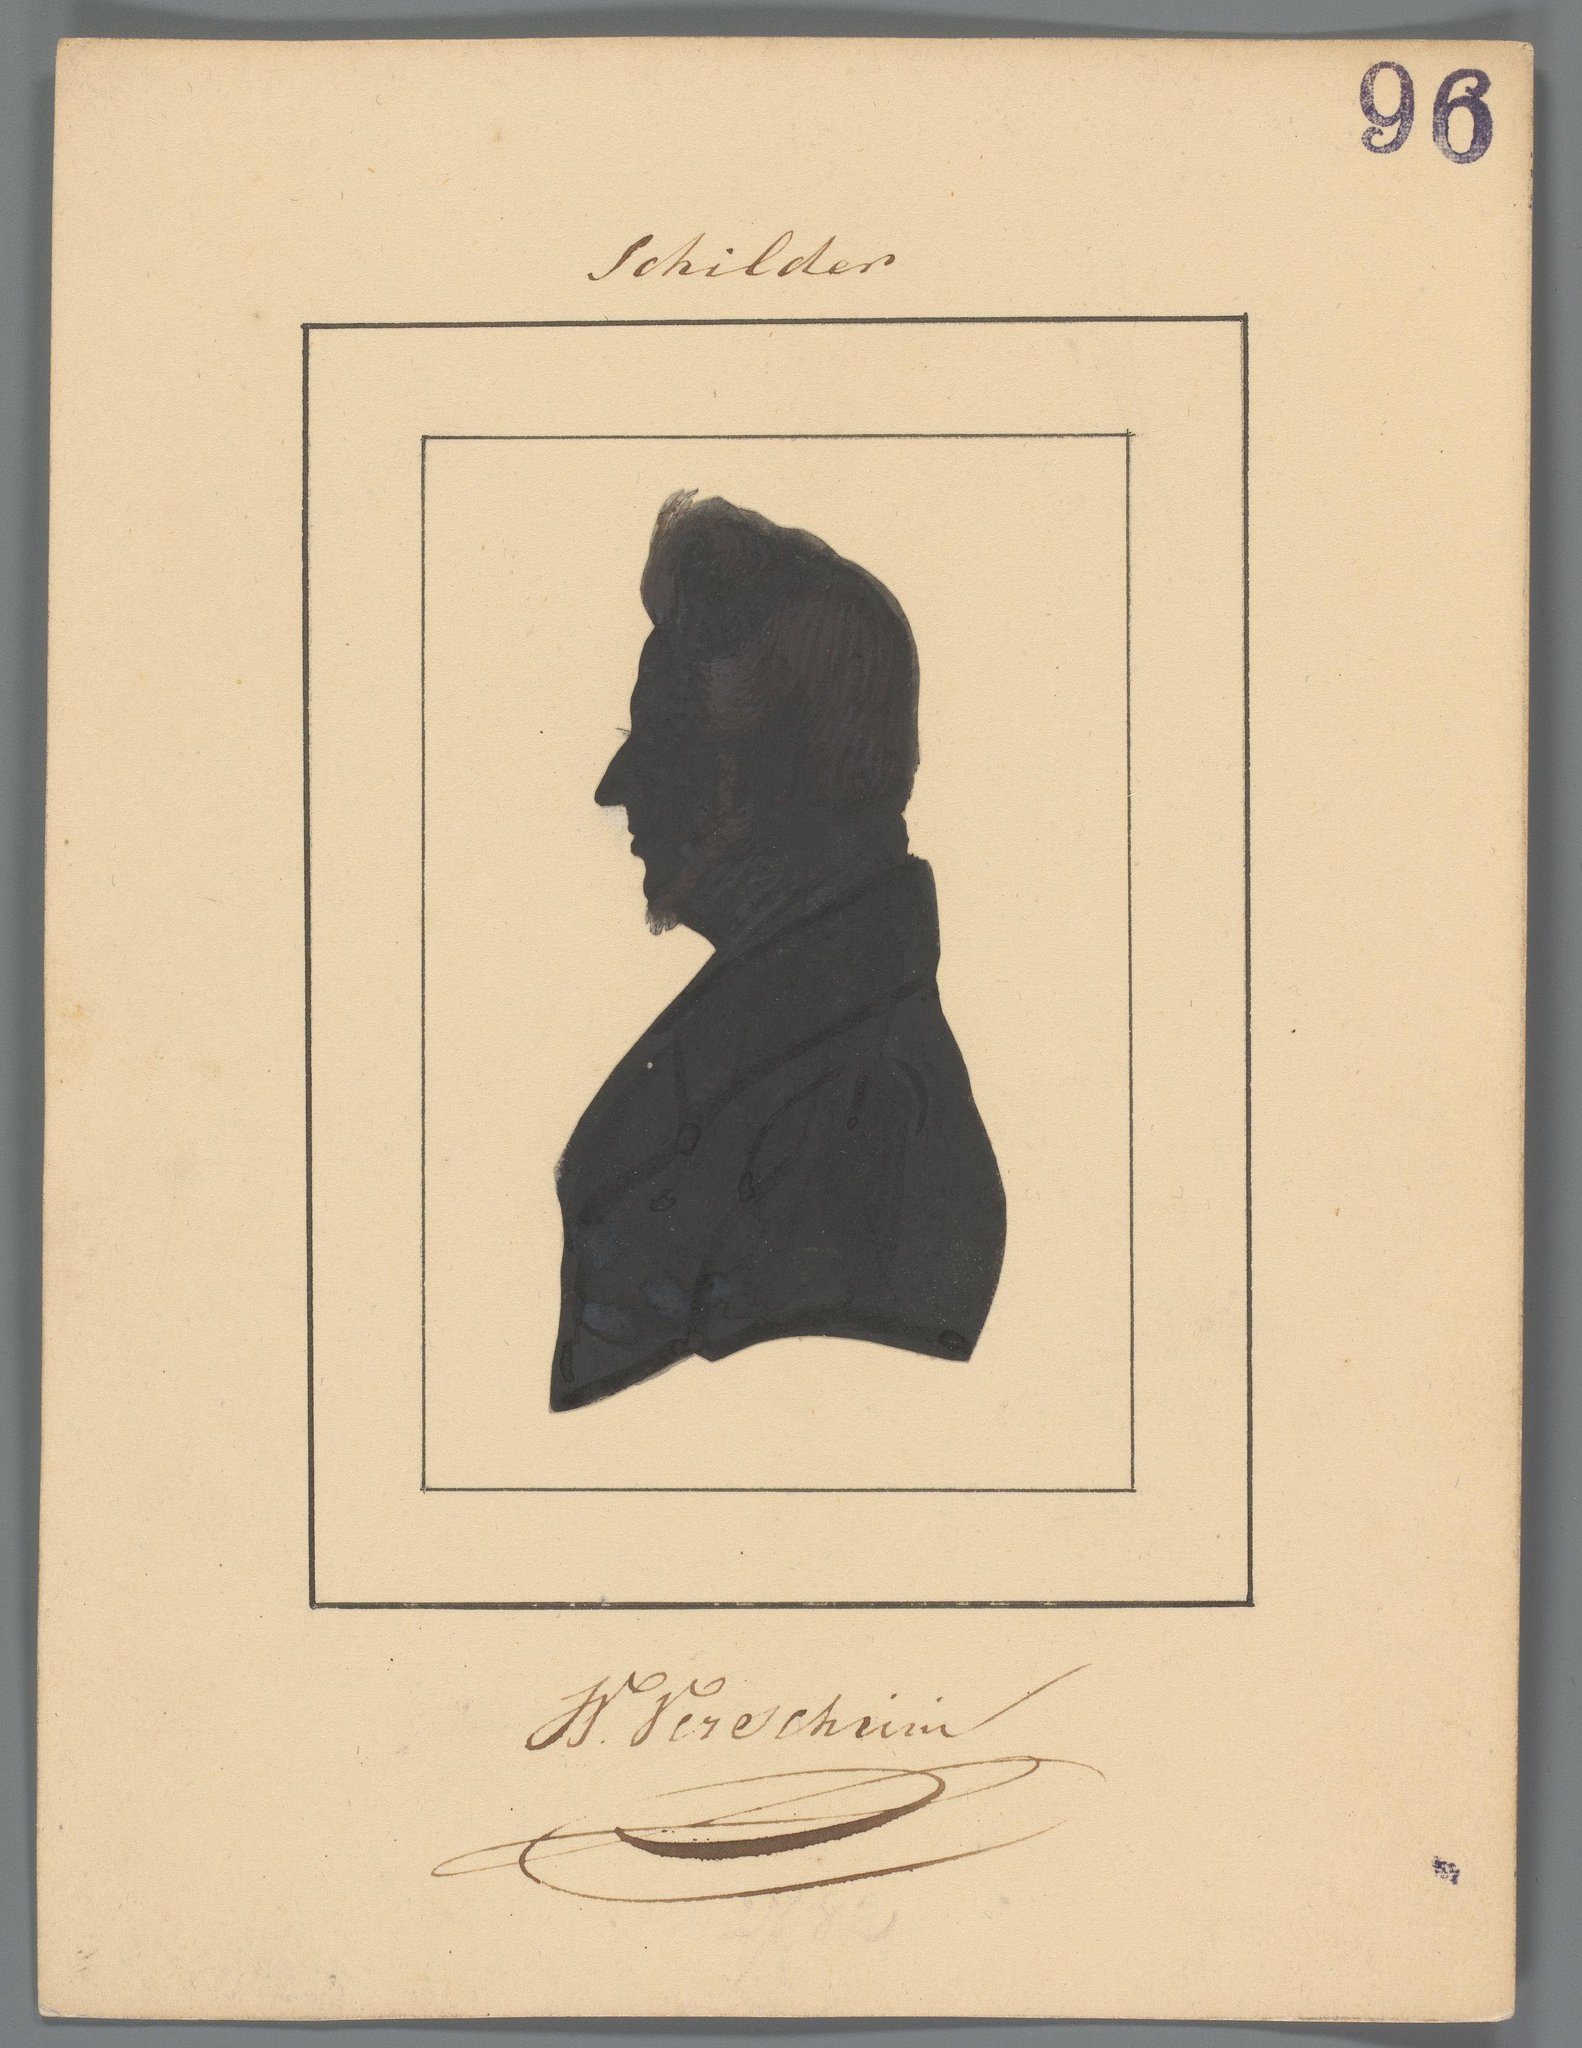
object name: silhouette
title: Silhouetportret van Wouterus Verschuur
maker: elisabeth alida haanen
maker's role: draughtsman, print maker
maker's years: 1809-1845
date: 1819-1845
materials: ink, paint, paper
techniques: brush, snipping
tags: painter, wouter verschuur (1812-1874), historical persons, portrait, self-portrait of painter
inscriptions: inscription: ‘W. Verschuur’, inscription: ‘Neg. D. 1752’, collector's mark: ‘Ex-libris van Beresteyn’, number: ‘14027’, number: ‘96’, inscription: ‘Schilder’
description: Met onder het portret de handtekening van de geportretteerde.